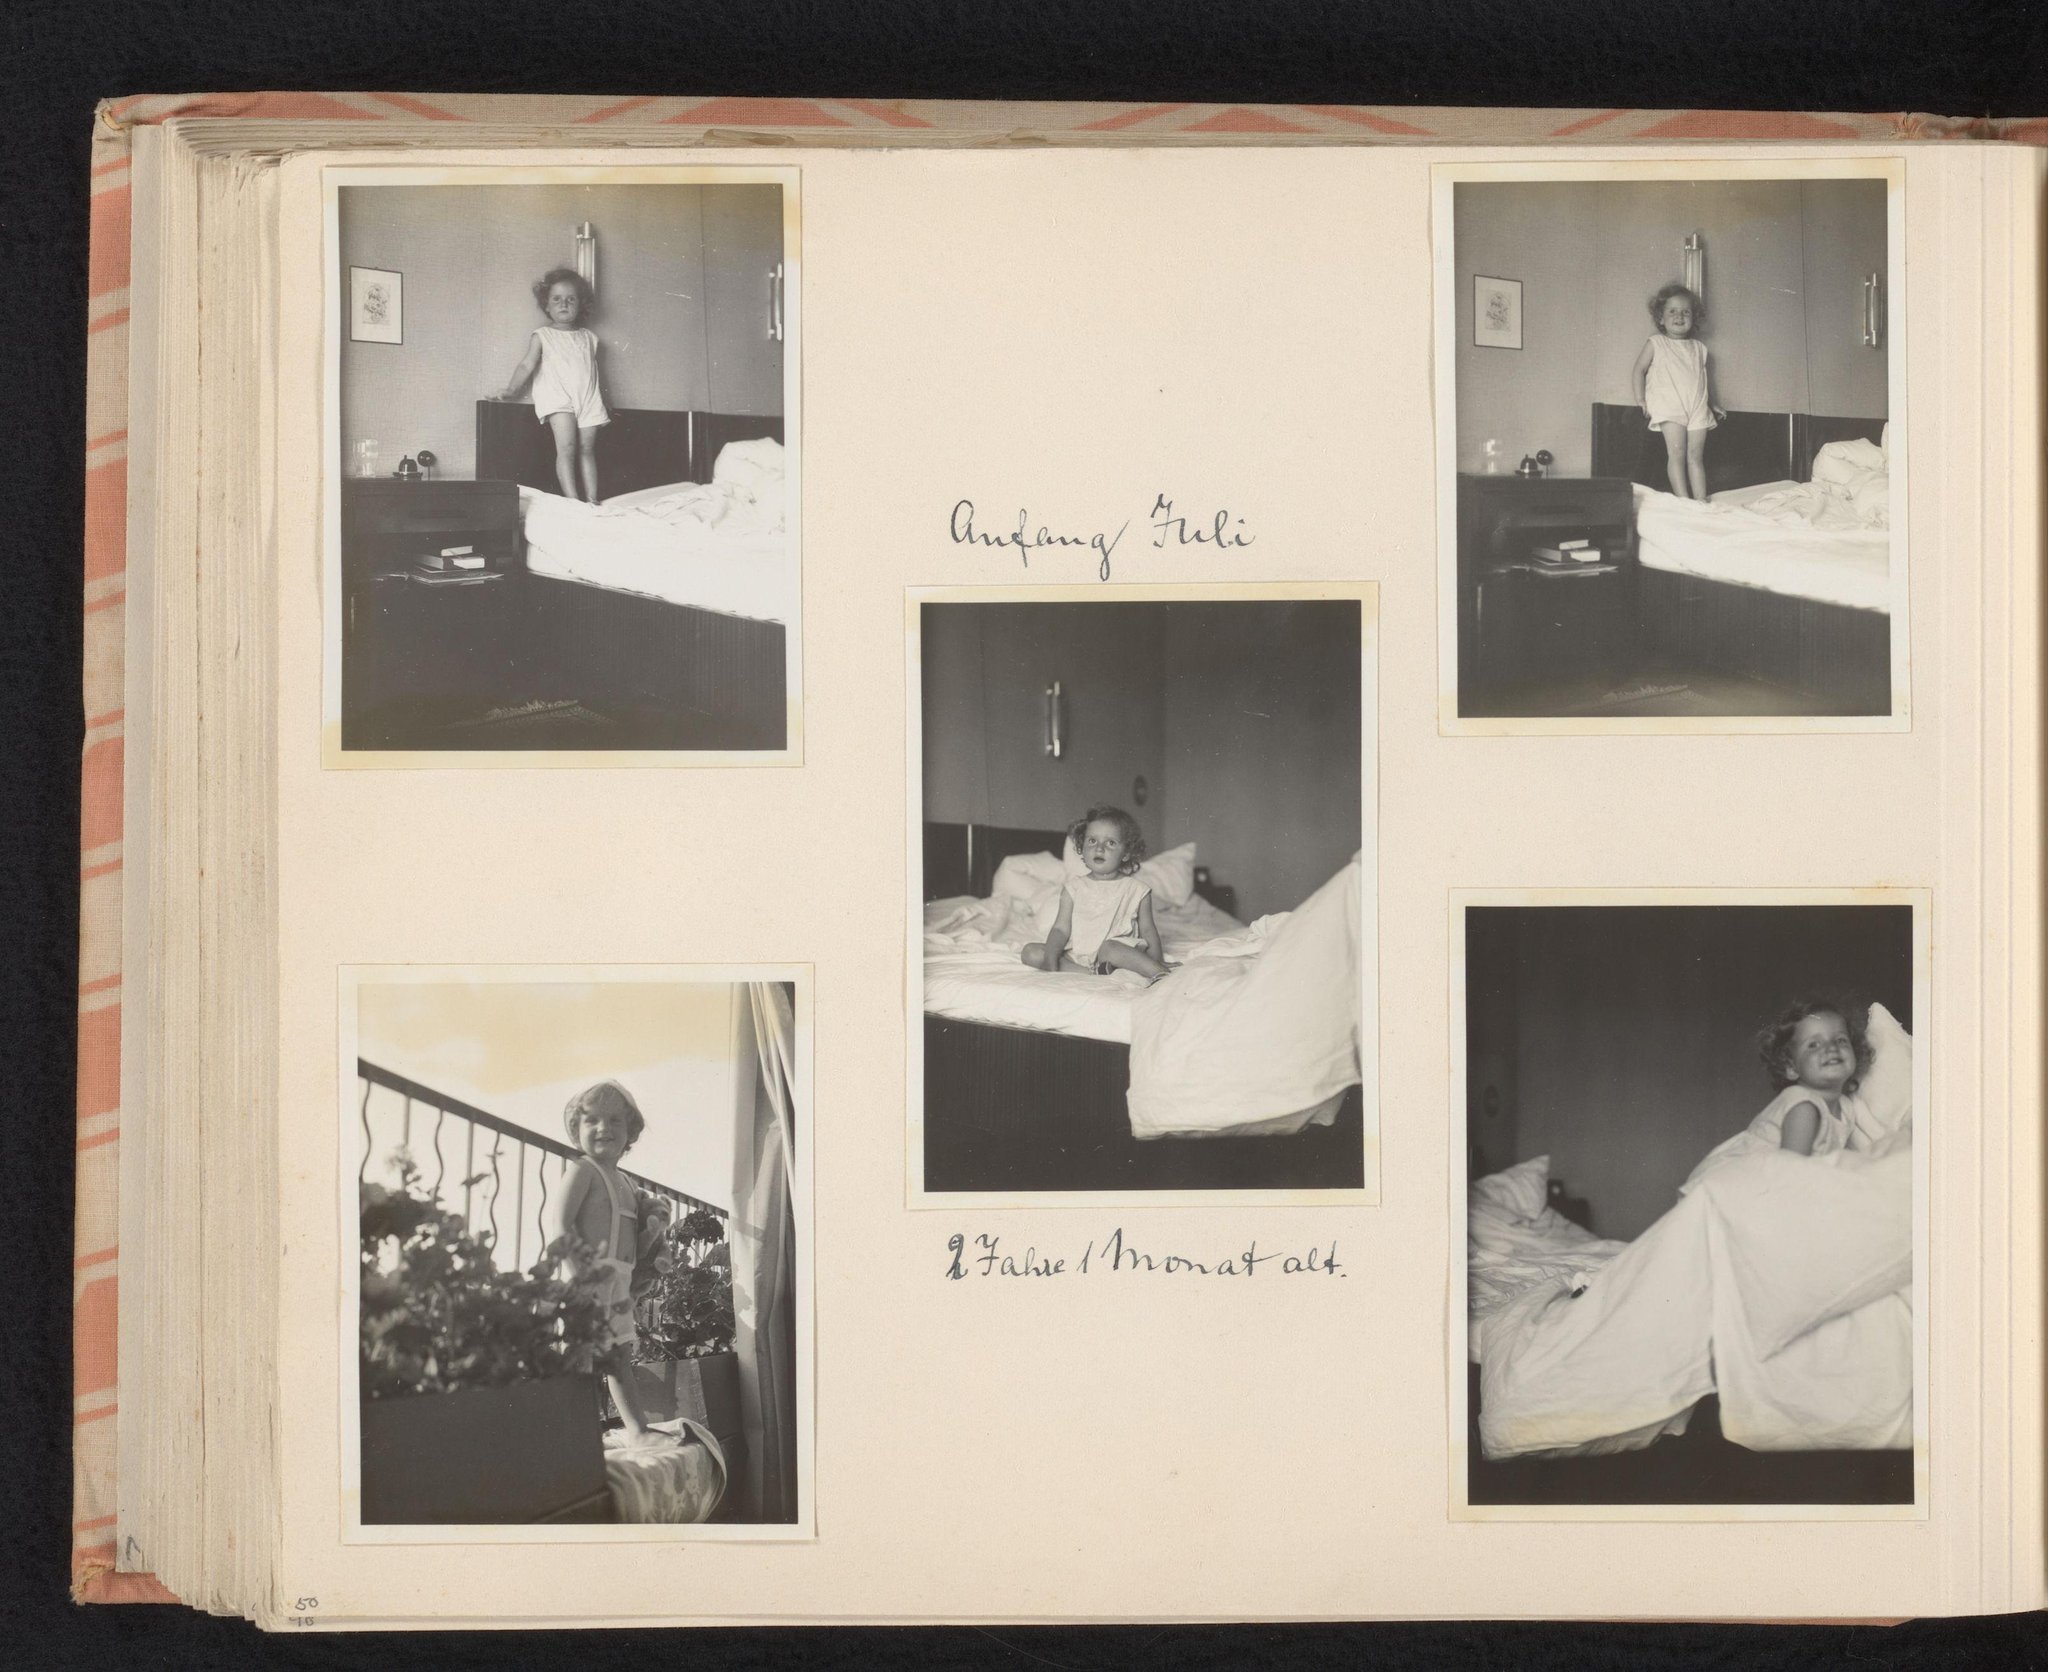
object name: album leaf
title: Isabel Wachenheimer in bed en op het balkon, begin juli 1930, München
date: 1907-1930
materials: paper, photographic support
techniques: gelatin silver print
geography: munich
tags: isabel wachenheimer-elon, family life at home, infant, baby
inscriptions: inscription: ‘Anfang Juli 2 Jahre 1 Monat alt.’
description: Albumblad met vijf foto's. Alle foto's, Isabel Wachenheimer. Onderdeel van het fotoalbum met foto's van Isabel Wachenheimer als kind (1928-1931).